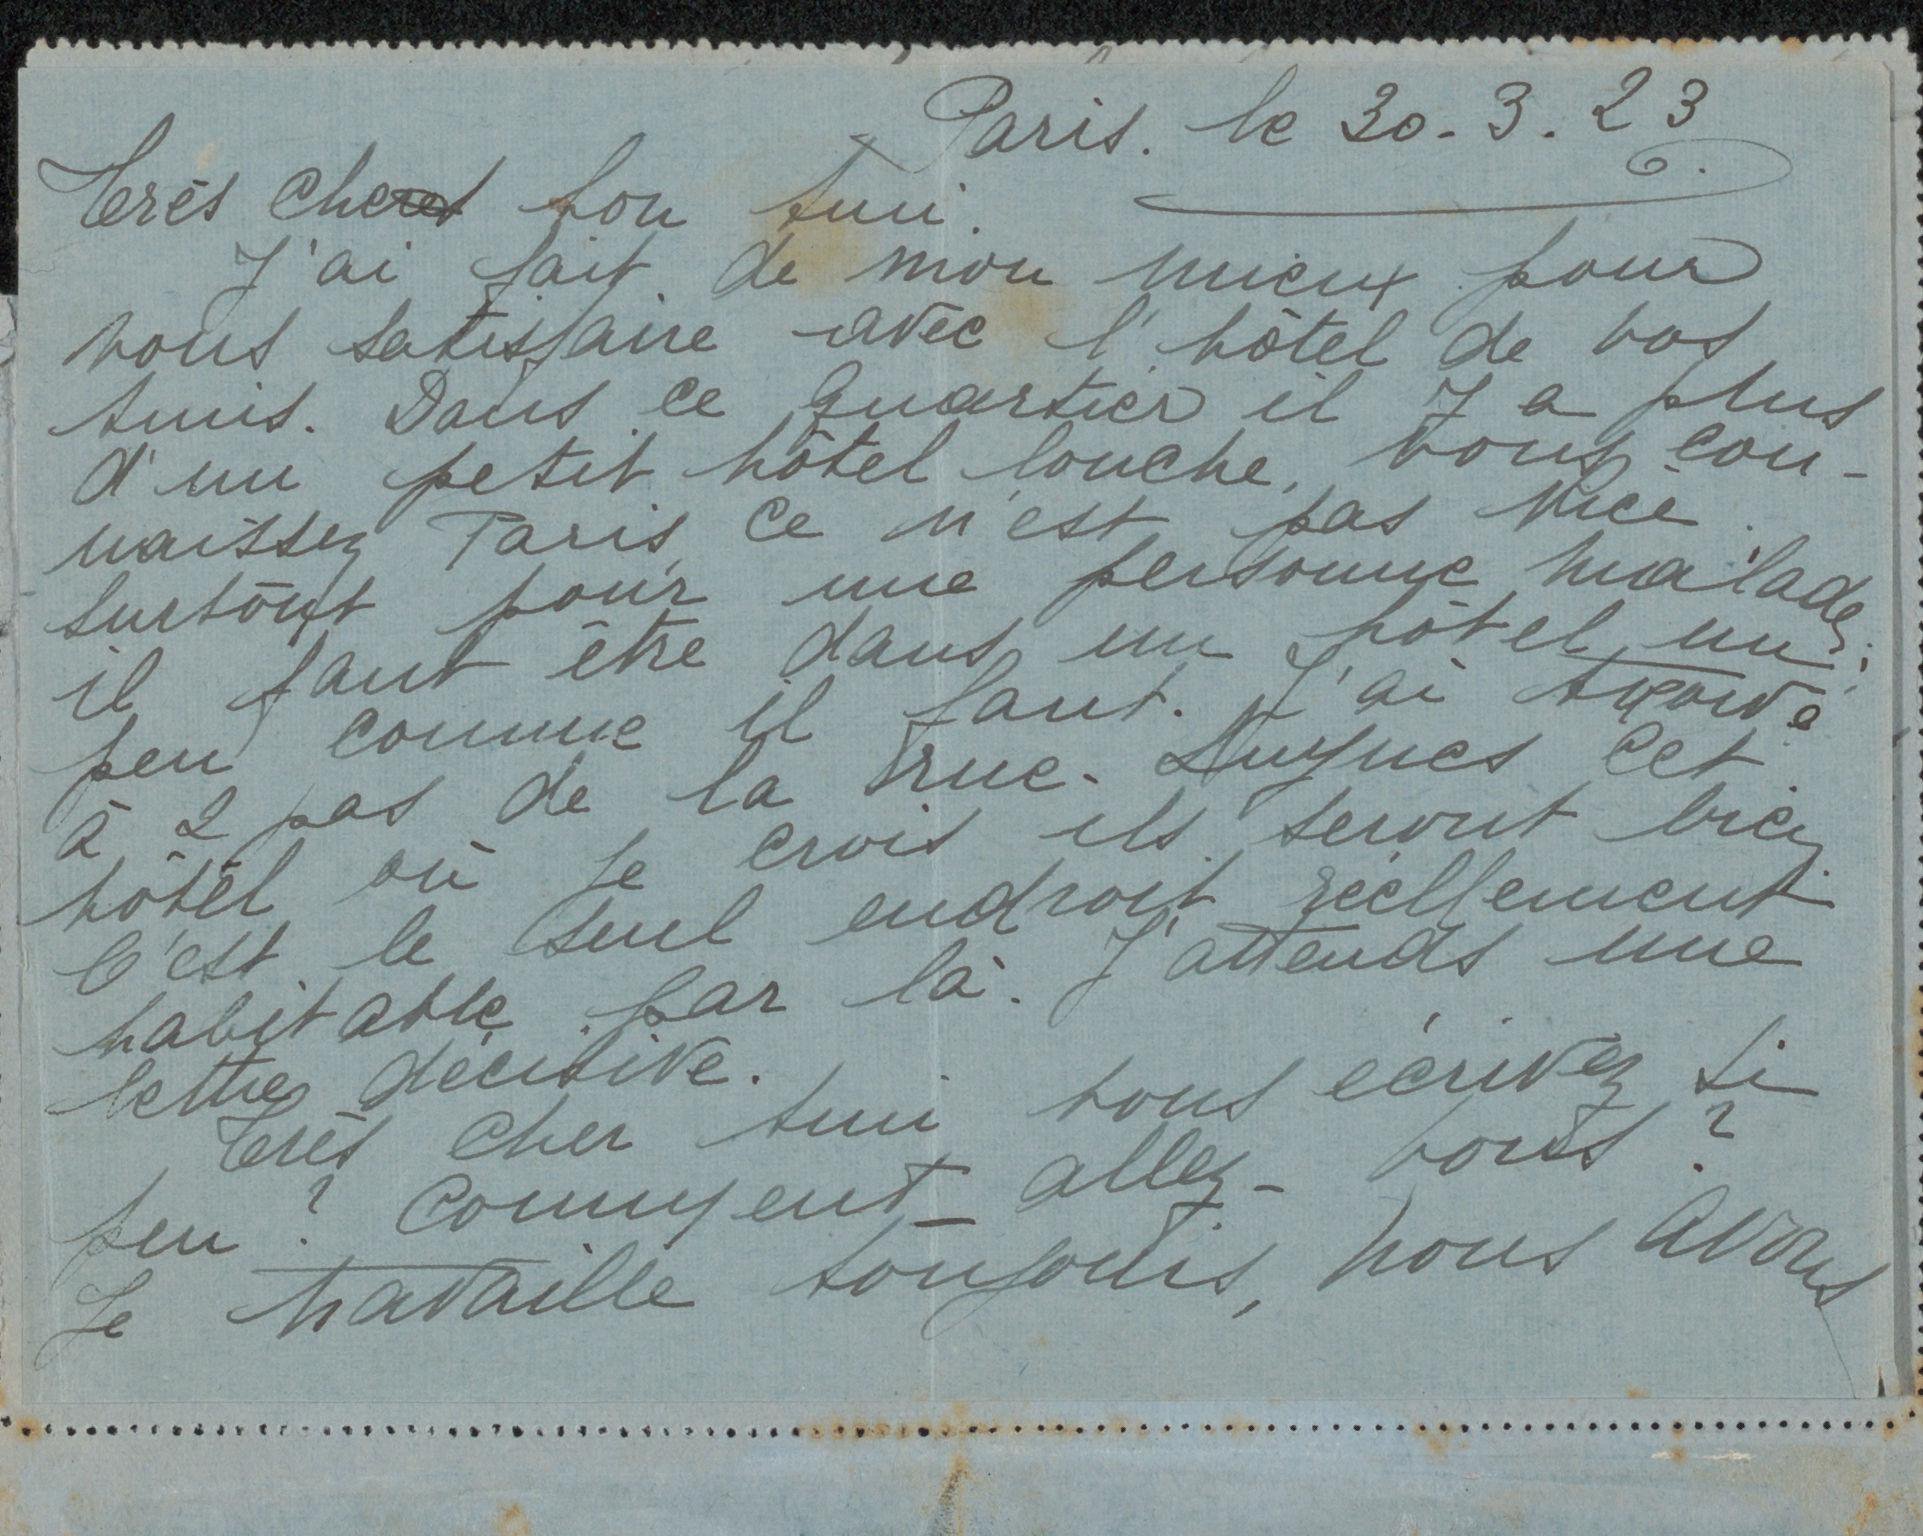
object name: letter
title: Brief aan Philip Zilcken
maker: rose imel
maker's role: draughtsman, painter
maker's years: 1901-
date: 1923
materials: ink, paper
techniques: pen, writing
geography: paris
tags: the hague, philip zilcken, paris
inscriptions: collector's mark: ‘RPK’